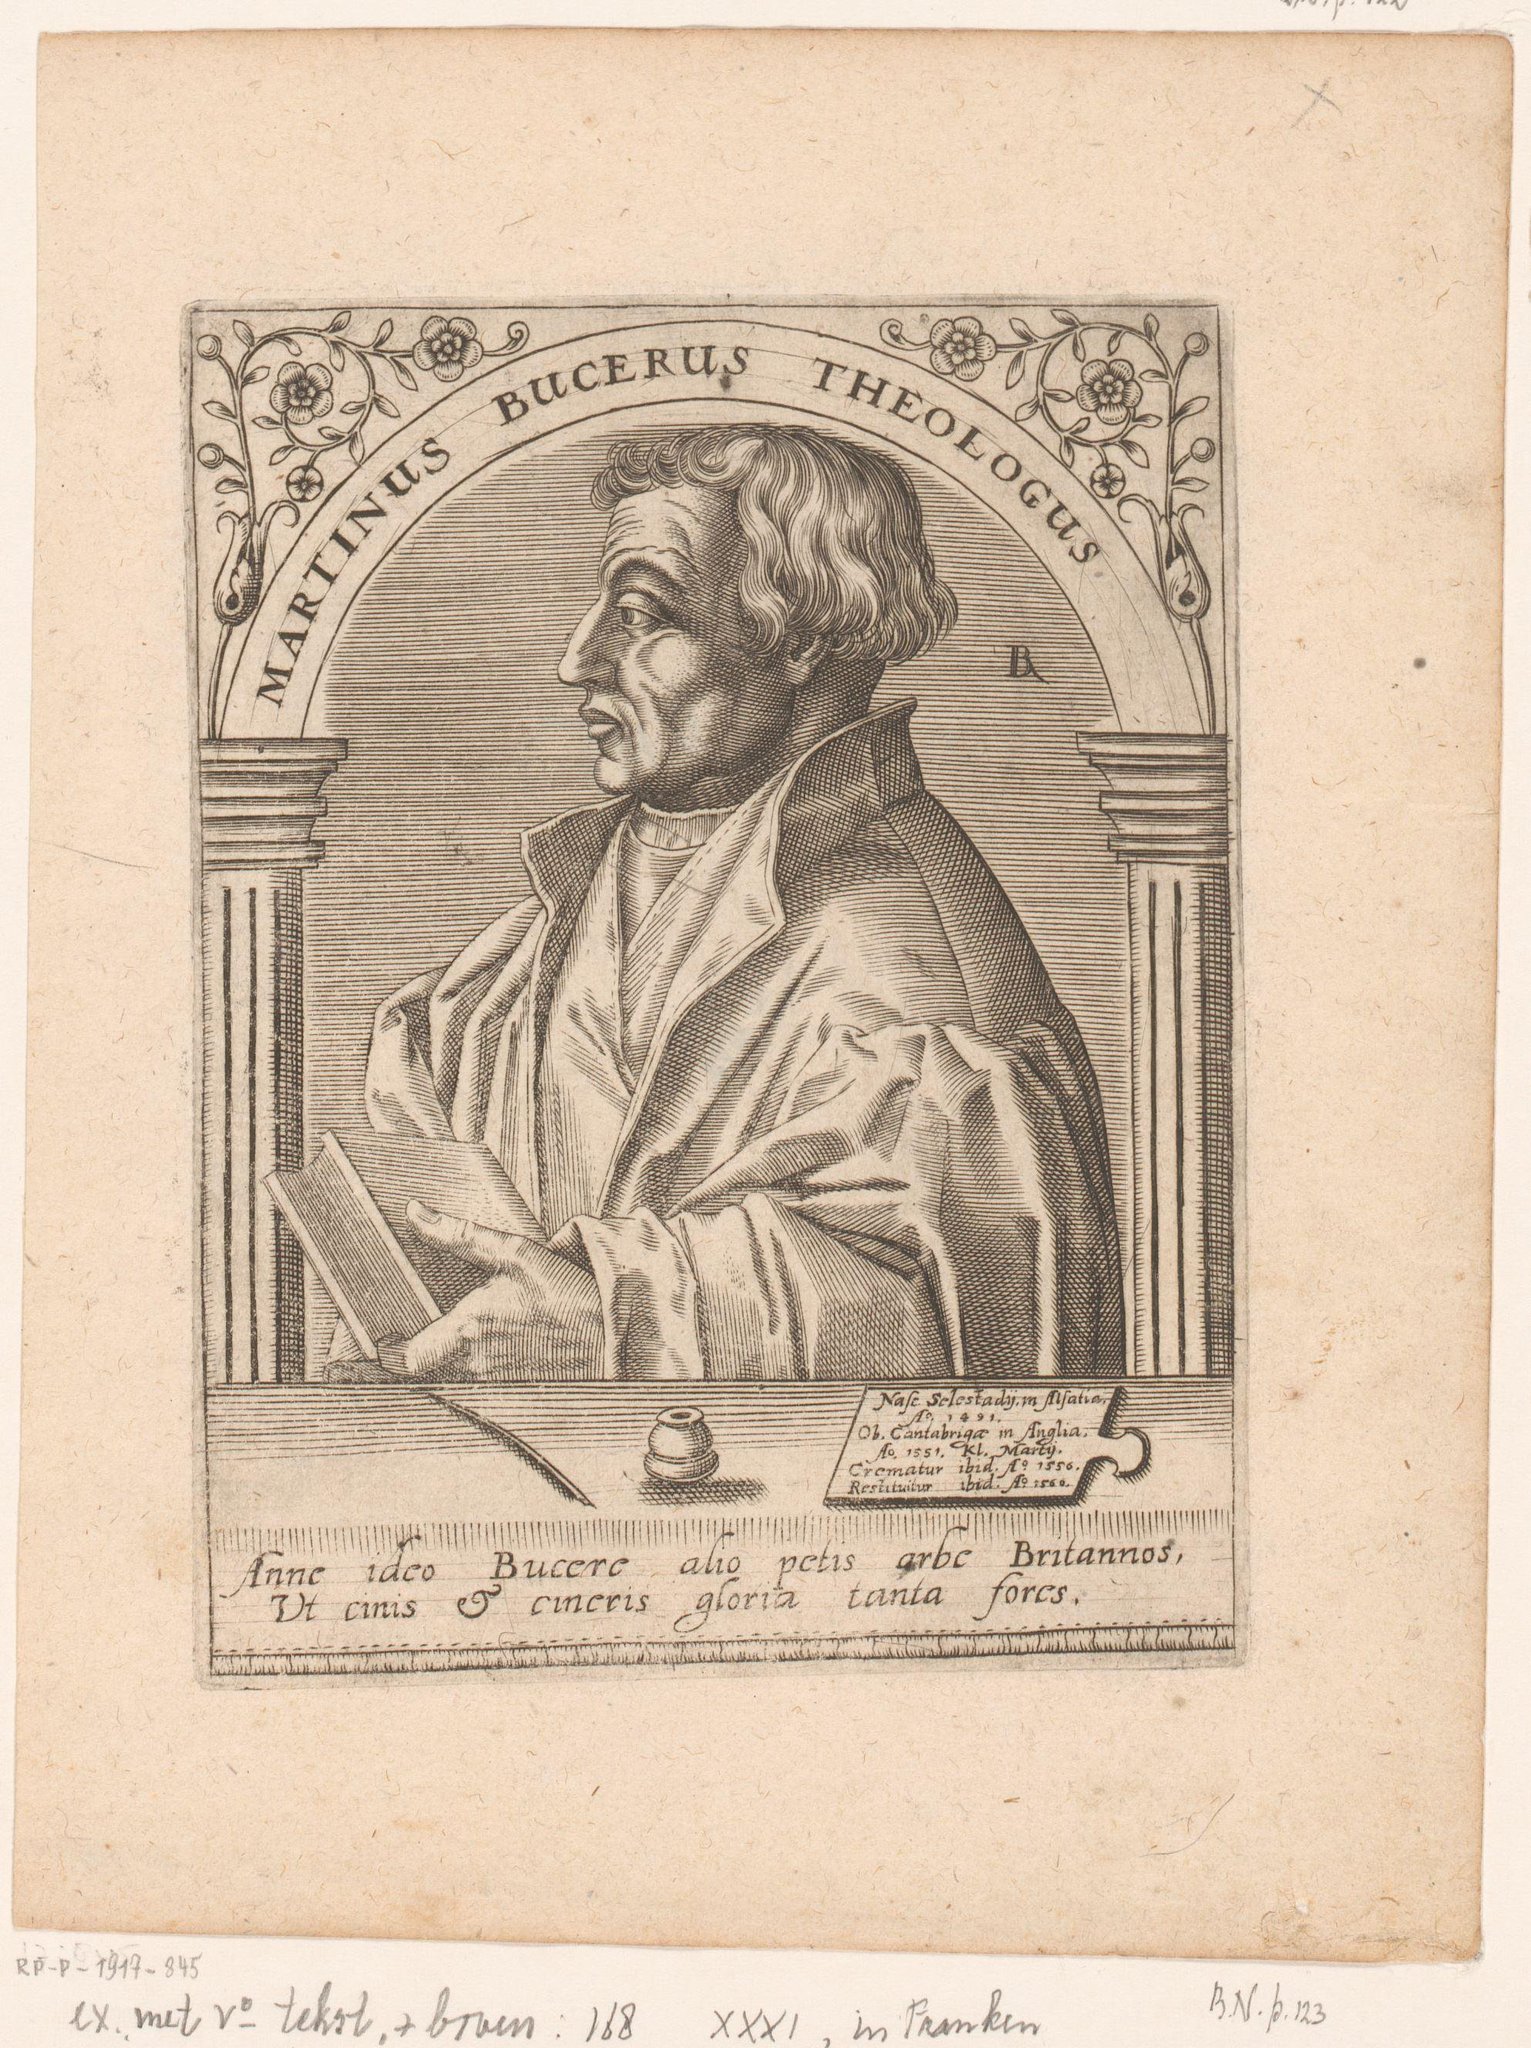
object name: print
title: Portret van Anton von Bucher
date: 1779-1843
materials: paper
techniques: stippling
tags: theologian, historical persons, portrait of a writer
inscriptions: collector's mark: Lugt 2228